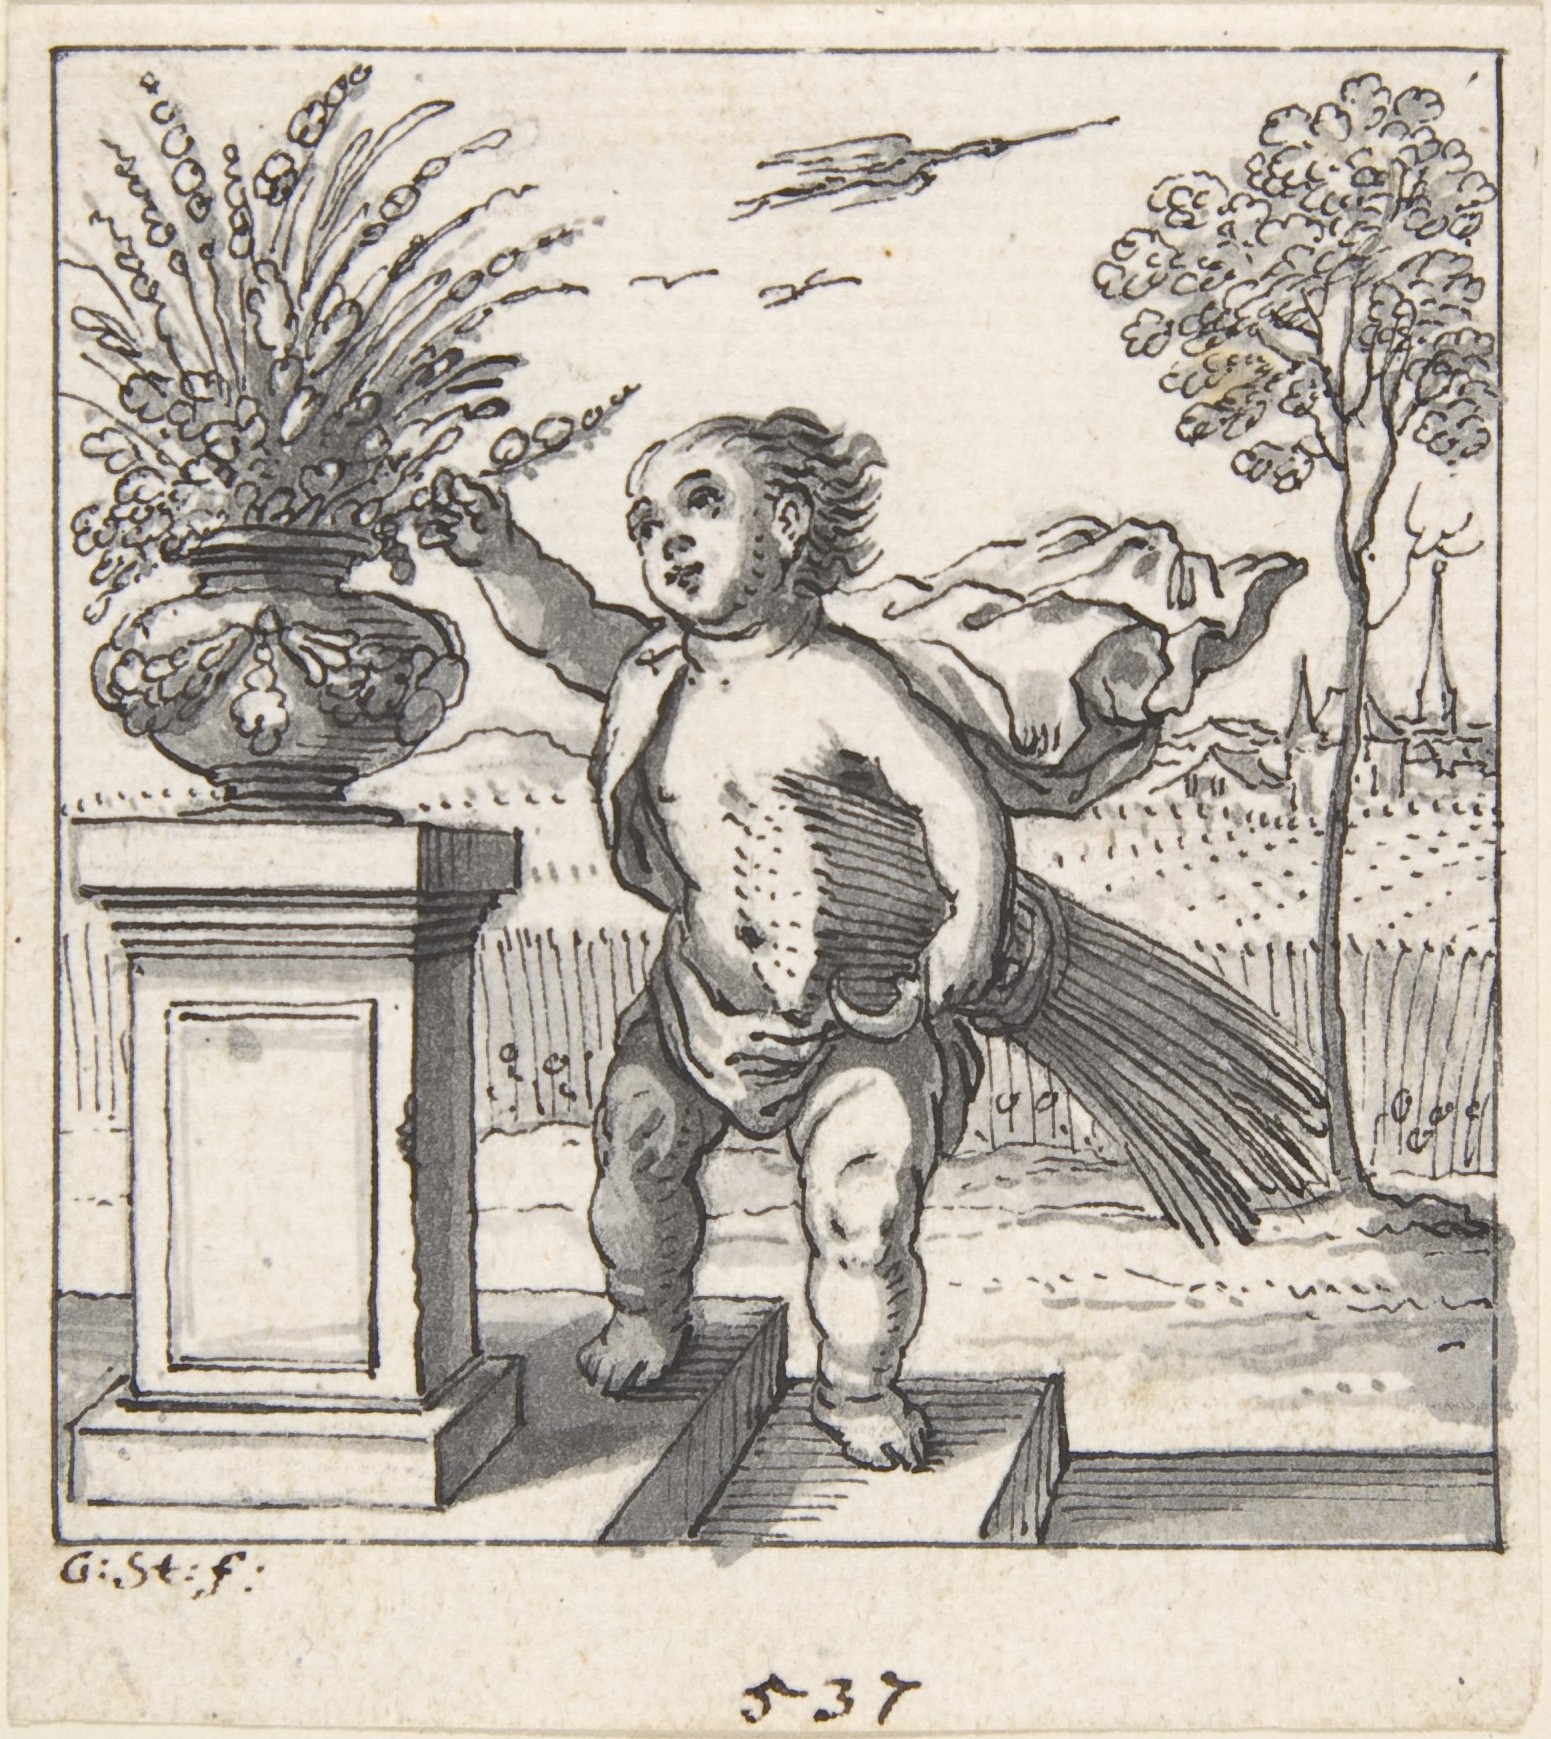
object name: drawing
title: Design for an Emblem with a Child Picking Flowers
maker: georg strauch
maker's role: artist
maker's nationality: german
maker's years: 1613-1675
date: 1633-1675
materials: ink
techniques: brush, pen, wash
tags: children,flowers,vases